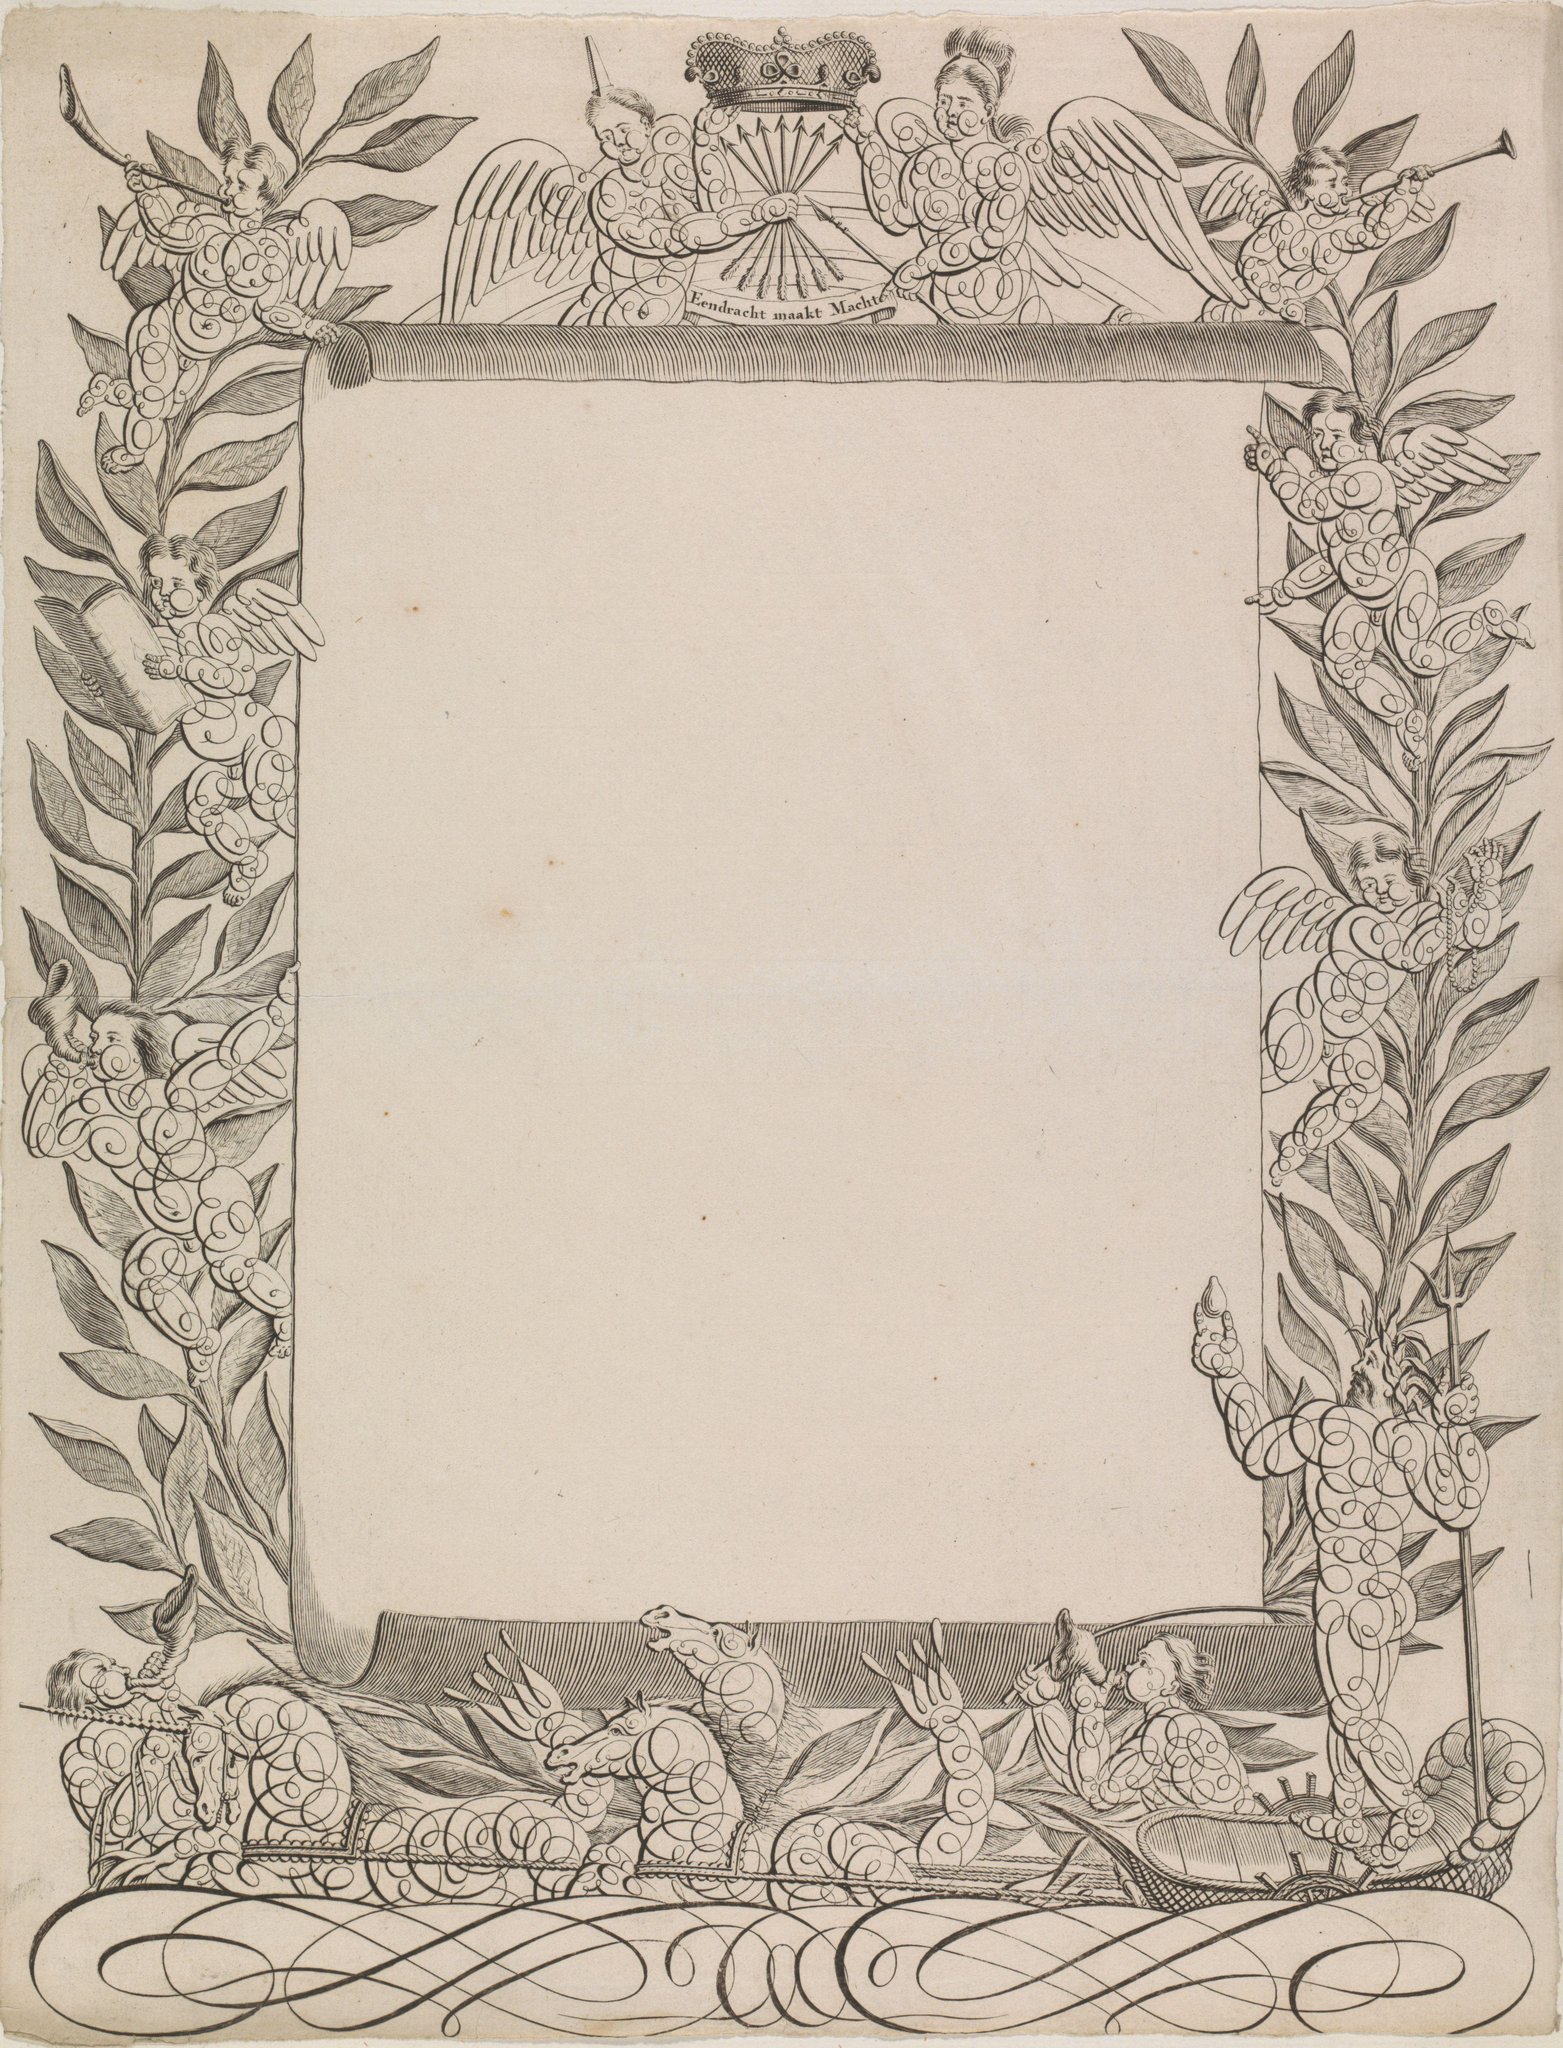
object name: wensbrief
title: Eendracht maakt macht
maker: Anonymous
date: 1700-1899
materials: paper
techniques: etching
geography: netherlands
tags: (story of) neptune (poseidon), sea-horse, hippocamp, 'hippocampus', (horse/fish) (mythological hybrid monster), cupids: 'amores', 'amoretti', 'putti'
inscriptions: collector's mark: Lugt 2760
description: Wensbrief met onbeschreven cartouche binnen een decoratief kader met voorstellingen van Neptunus staand op zijn wagen die wordt getrokken door hippocampussen en van putti met verschillende attributen. De figuren bestaan grotendeels uit krullen (kalligrafie).